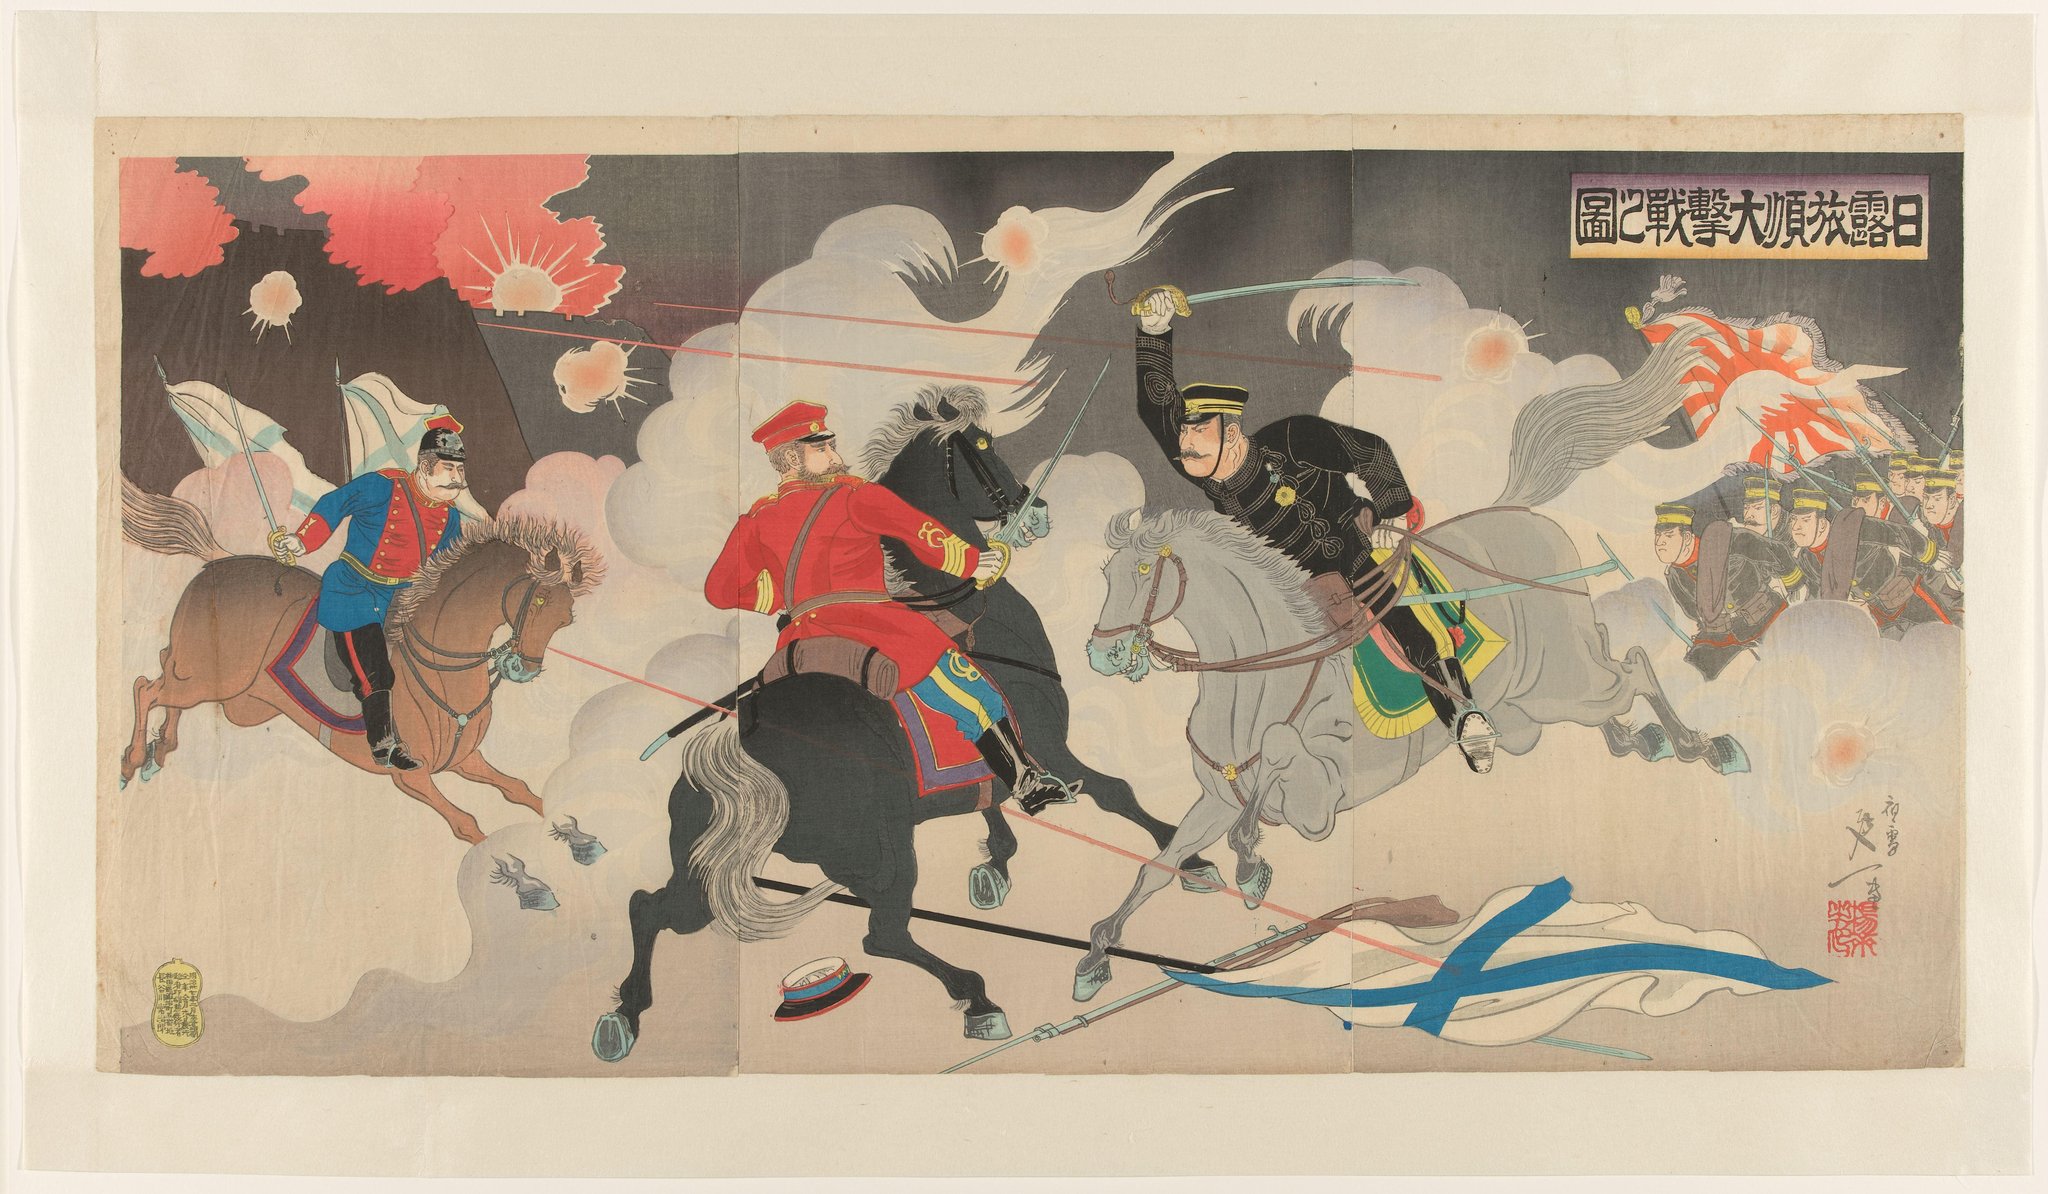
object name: triptych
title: De grote slag bij Port Arthur tijdens de Russisch-Japanse Oorlog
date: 1904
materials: paper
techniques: woodcut, polish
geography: japan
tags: riding a horse, ass, or mule; rider, horseman, battle, officer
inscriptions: collector's mark: Lugt 2228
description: Een Russische officier in rood vecht met een Japanse officier in zwart uniform, van beide kanten trekken soldaten ten strijde. In februari 1904 valt Japan de Russische vloot aan bij Port Arthur. Dit gebeurde enkel te water, dit gevecht op land heeft in die maand nooit plaats gevonden.